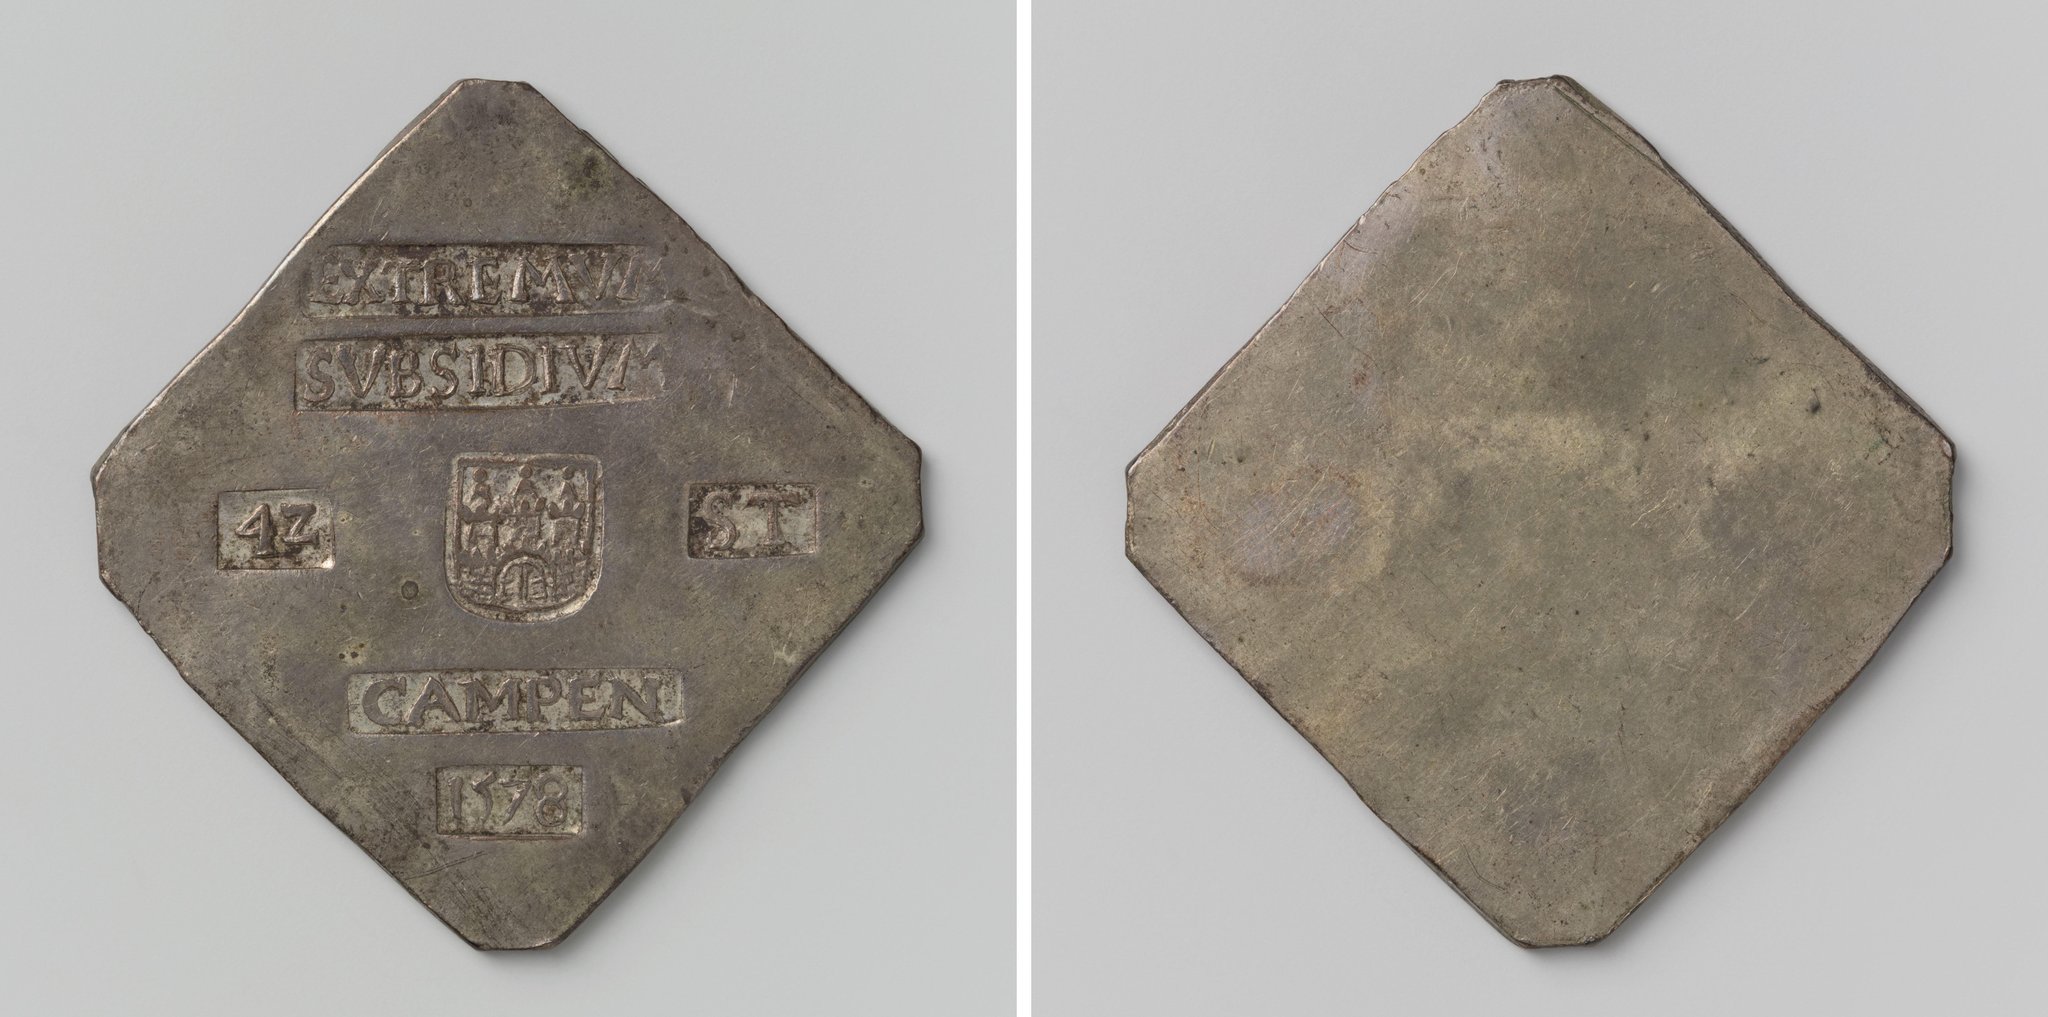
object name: coin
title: Tweeënveertig stuiver, noodmunt uit Kampen, geslagen ter betaling van achterstallige soldij aan het garnizoen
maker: Anonymous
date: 1507-1578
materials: silver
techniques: striking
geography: kampen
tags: kampen, tachtigjarige oorlog, inname van kampen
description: eenzijdige, ruitvormige noodmunt met afgeschuinde hoeken. Voorzijde: zeven stempels: wapenschild tussen waardeaanduiding, onder en boven opschriften. Keerzijde: blanco